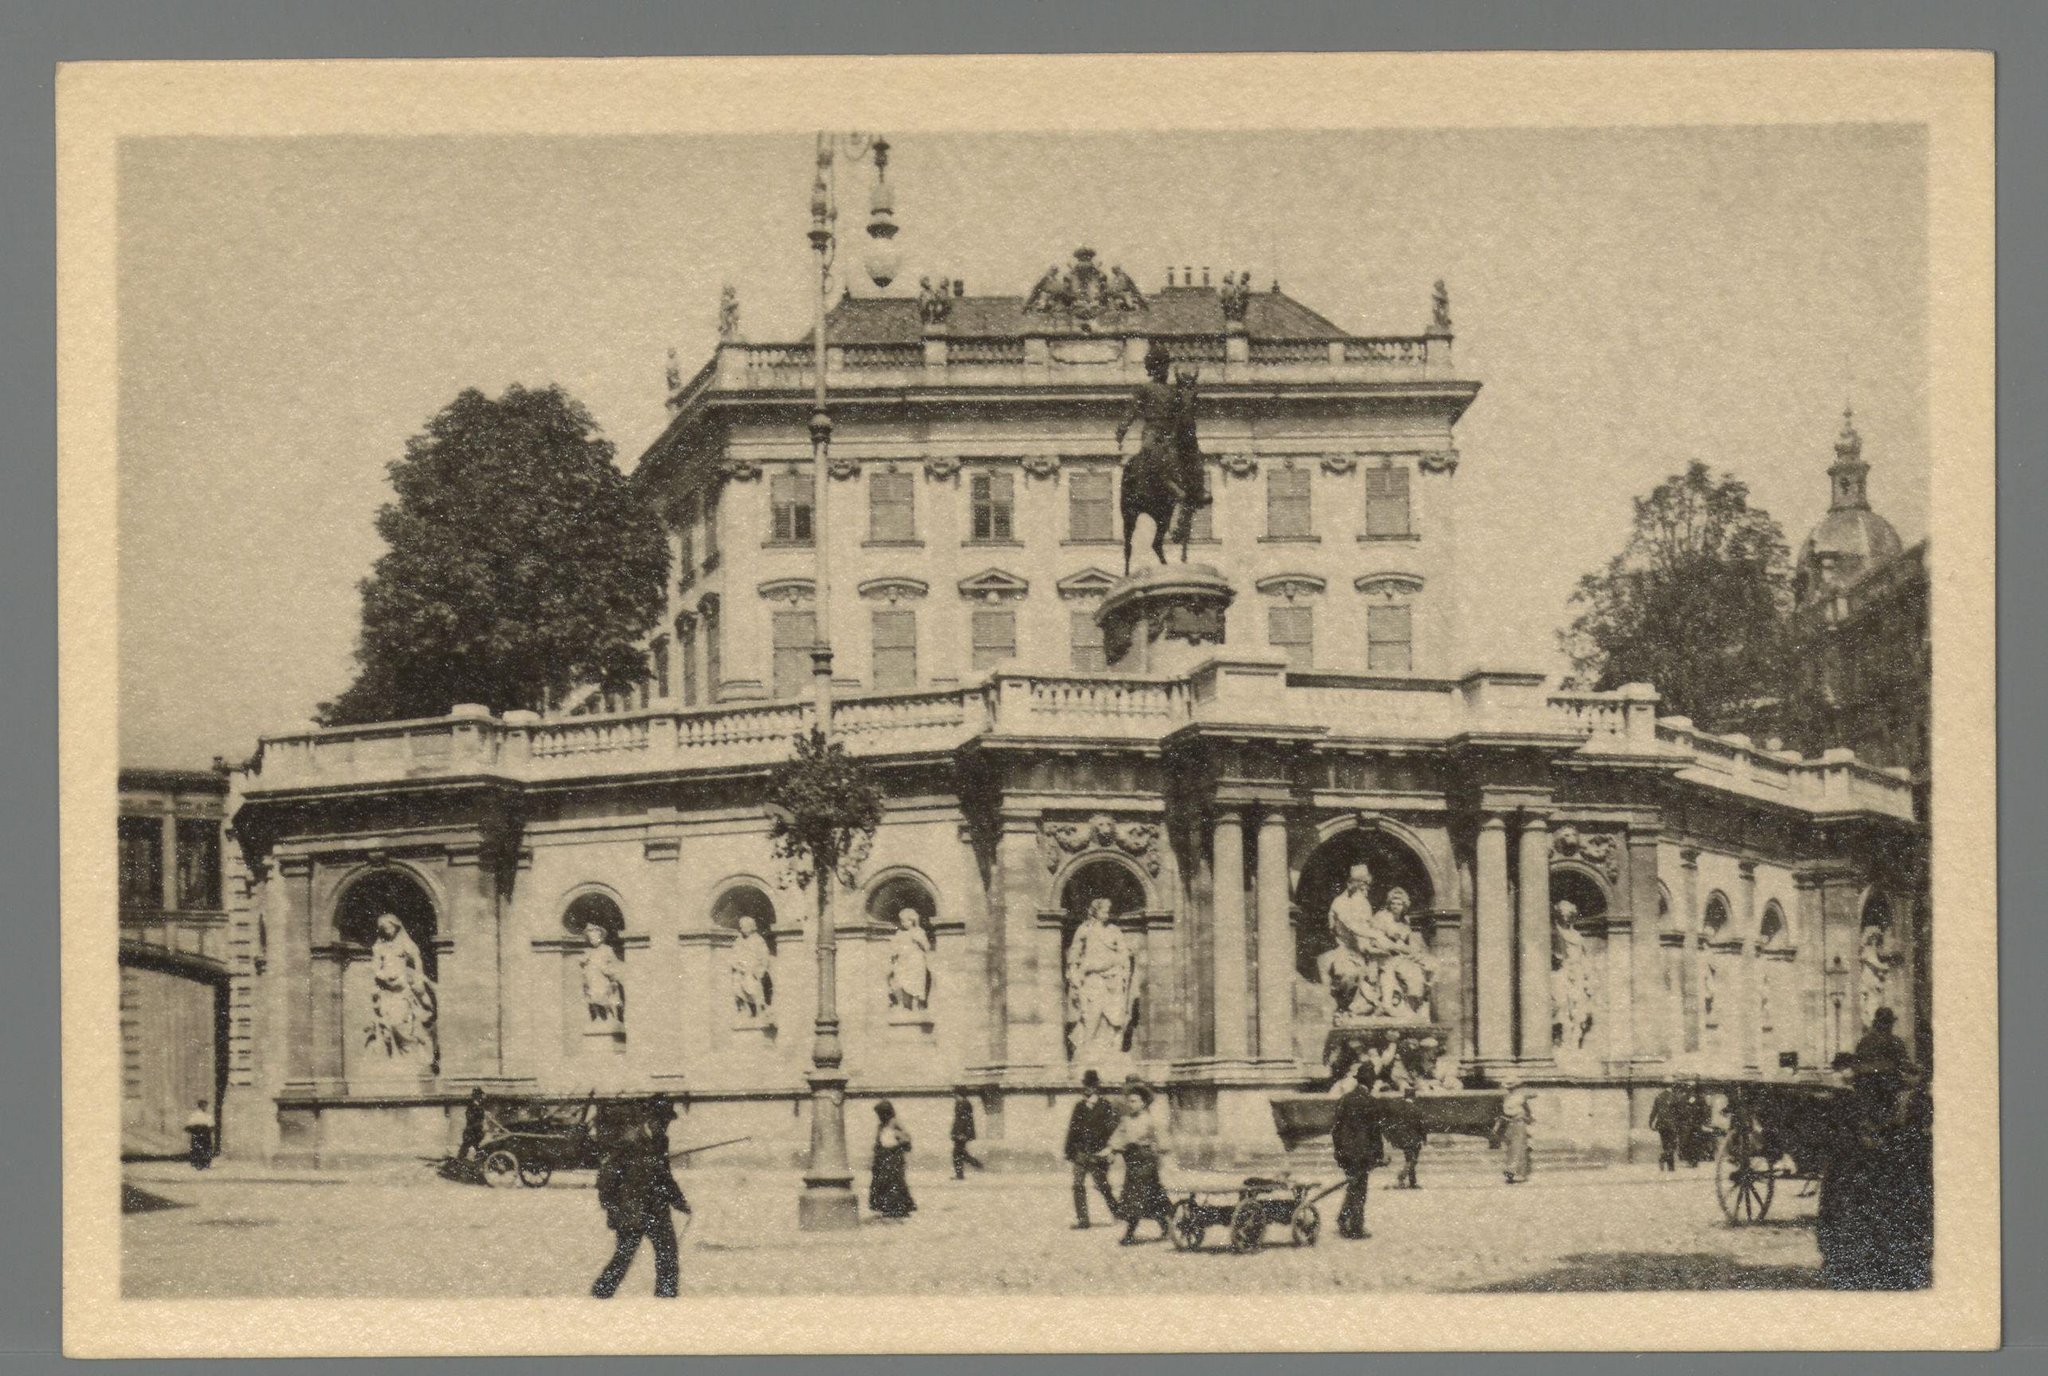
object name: ansichtkaart, prentbriefkaart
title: Wien, Albrechtsbrunnen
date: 1904-1930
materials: paper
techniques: gelatin silver print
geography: vienna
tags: ornamental fountain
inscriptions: inscription: ‘K.L. Wien’